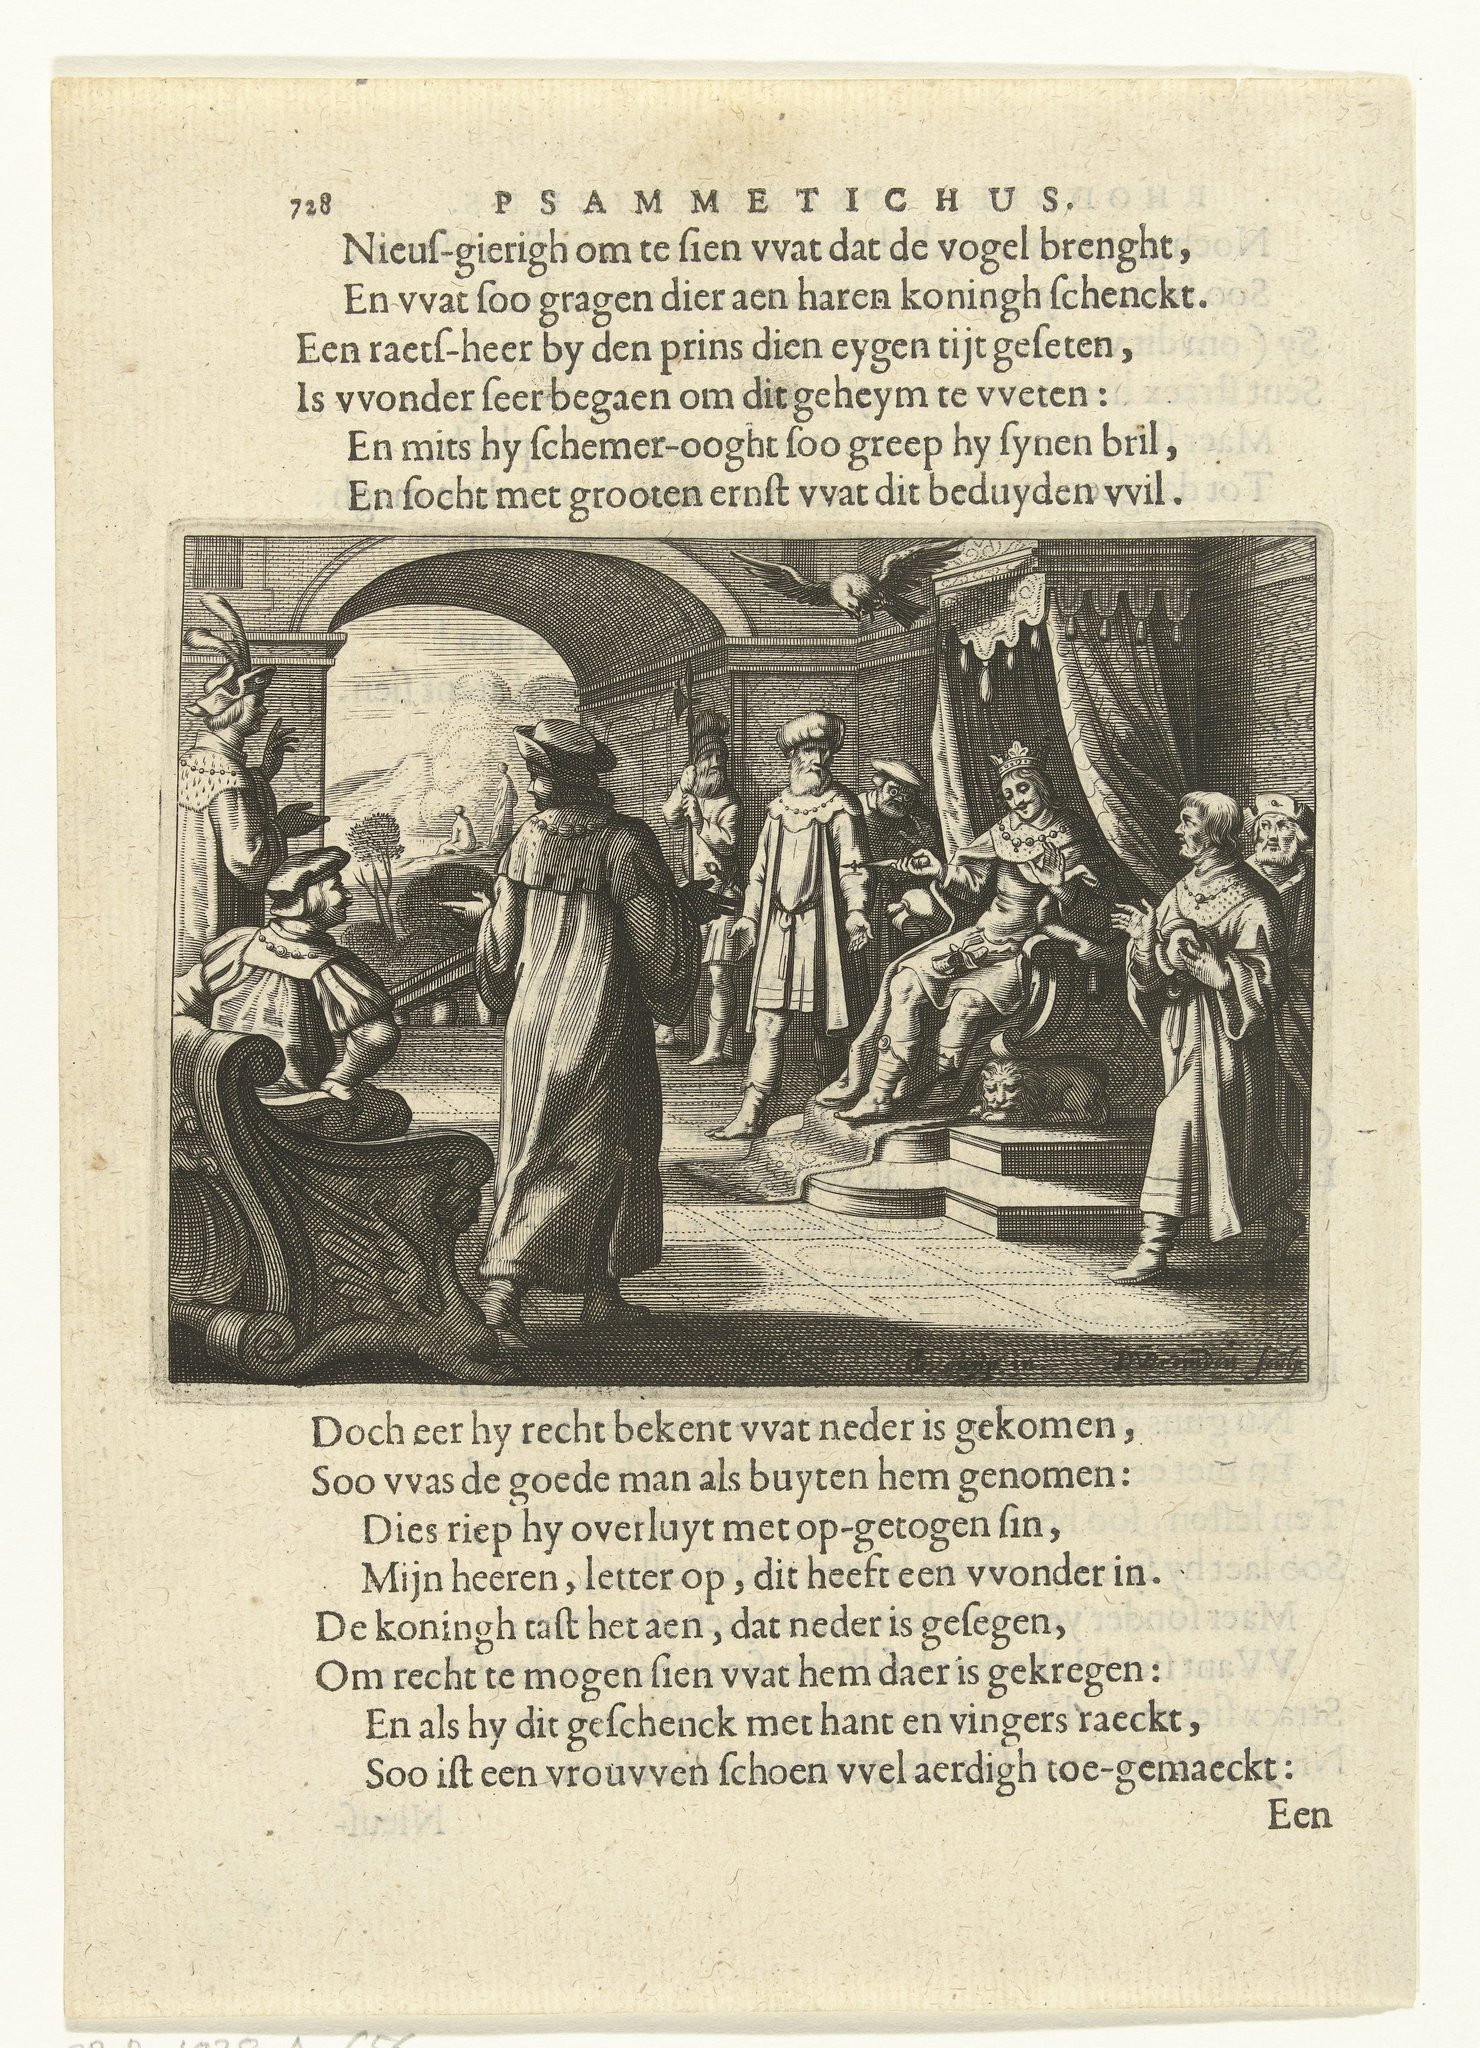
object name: print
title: Psammetichus ontvangt een vrouwenschoen van een adelaar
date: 1537-1635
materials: paper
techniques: engraving, letterpress printing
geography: amsterdam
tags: psammetichus, king of egypt, and the courtesan rhodopis; cupid assists her in putting on her sandal (while she was bathing one day an eagle carried away one of her sandals and dropped it near pharaoh, who started to look for its owner)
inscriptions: collector's mark: Lugt 2228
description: De Egyptische farao Psammetichus zit op een troon in zijn troonzaal omgeven van medewerkers. Een adelaar vliegt in het paleis en werpt een vrouwenschoen in de schoot van de farao. Bladzijde uit een boek met tekst op recto en verso.